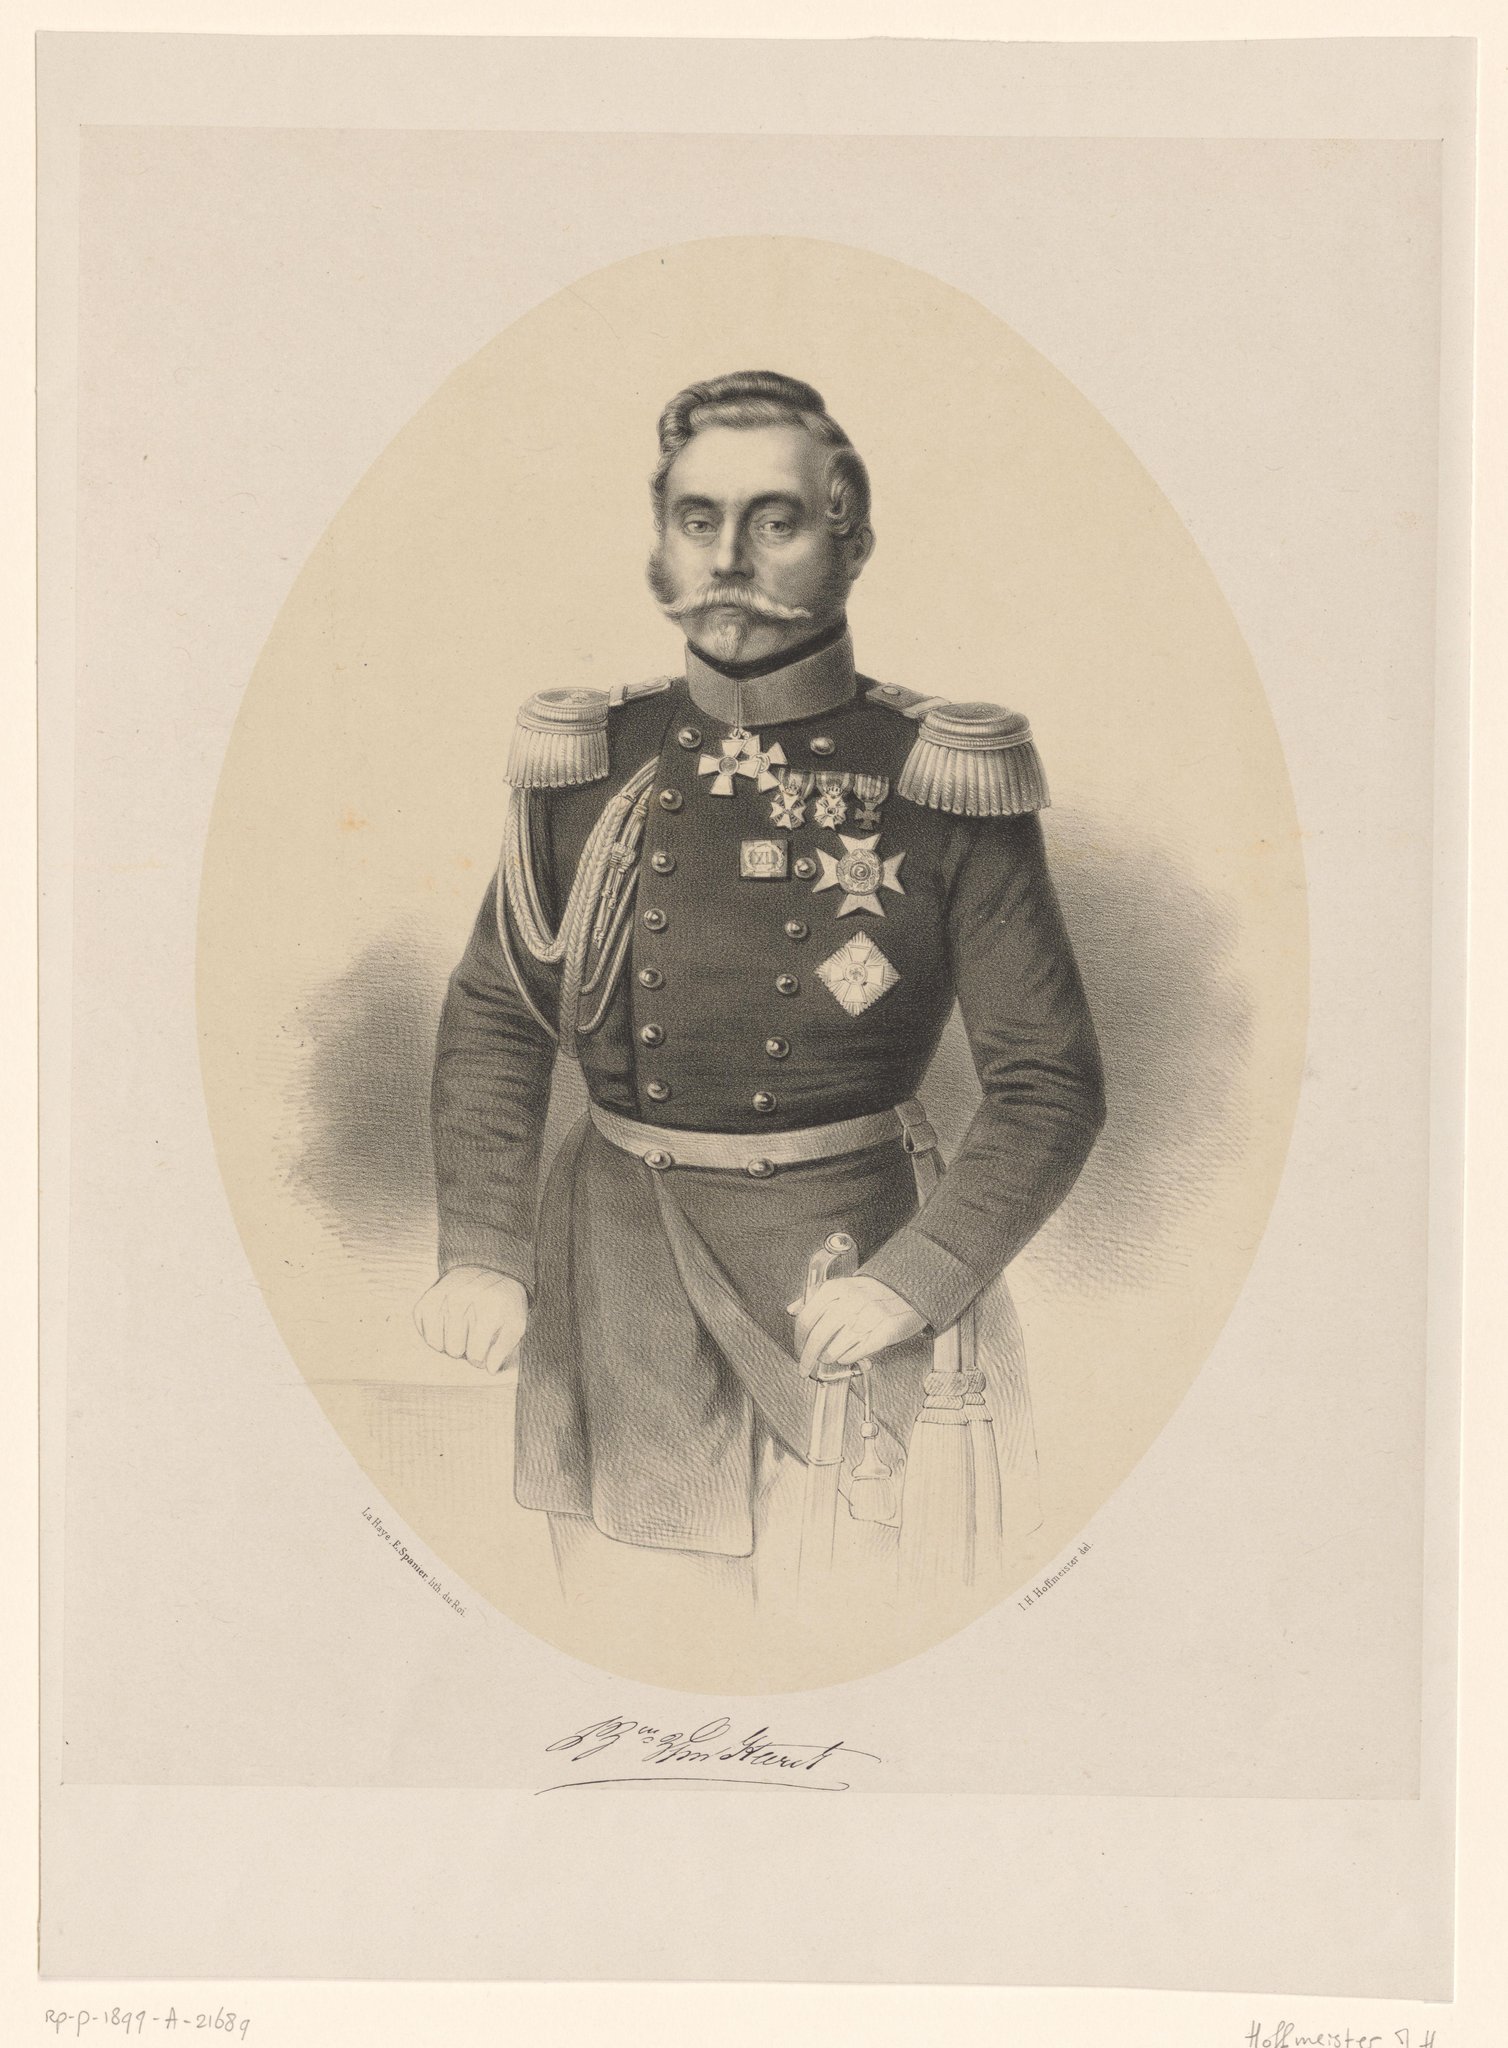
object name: print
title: Portret van Charles Eduard van Heerdt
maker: johan hendrik hoffmeister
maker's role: print maker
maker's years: 1823-1904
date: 1851-1883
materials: paper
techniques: tone lithography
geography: the hague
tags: the hague, historical persons, commander-in-chief, admiral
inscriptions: collector's mark: Lugt 2228